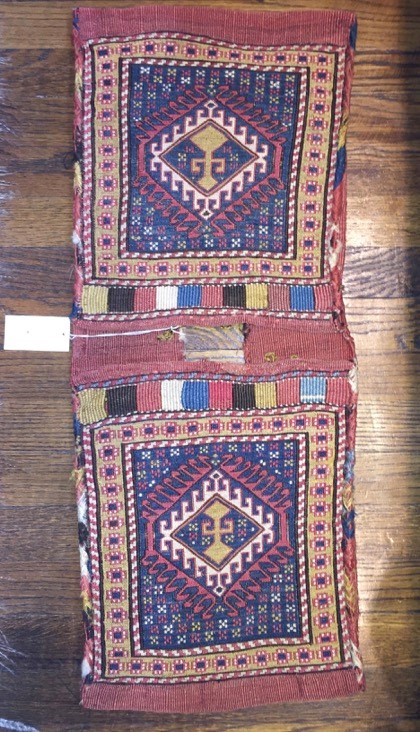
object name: saddle bag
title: Shahsevan Double Saddle Bag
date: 1860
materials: cotton, wool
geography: iran